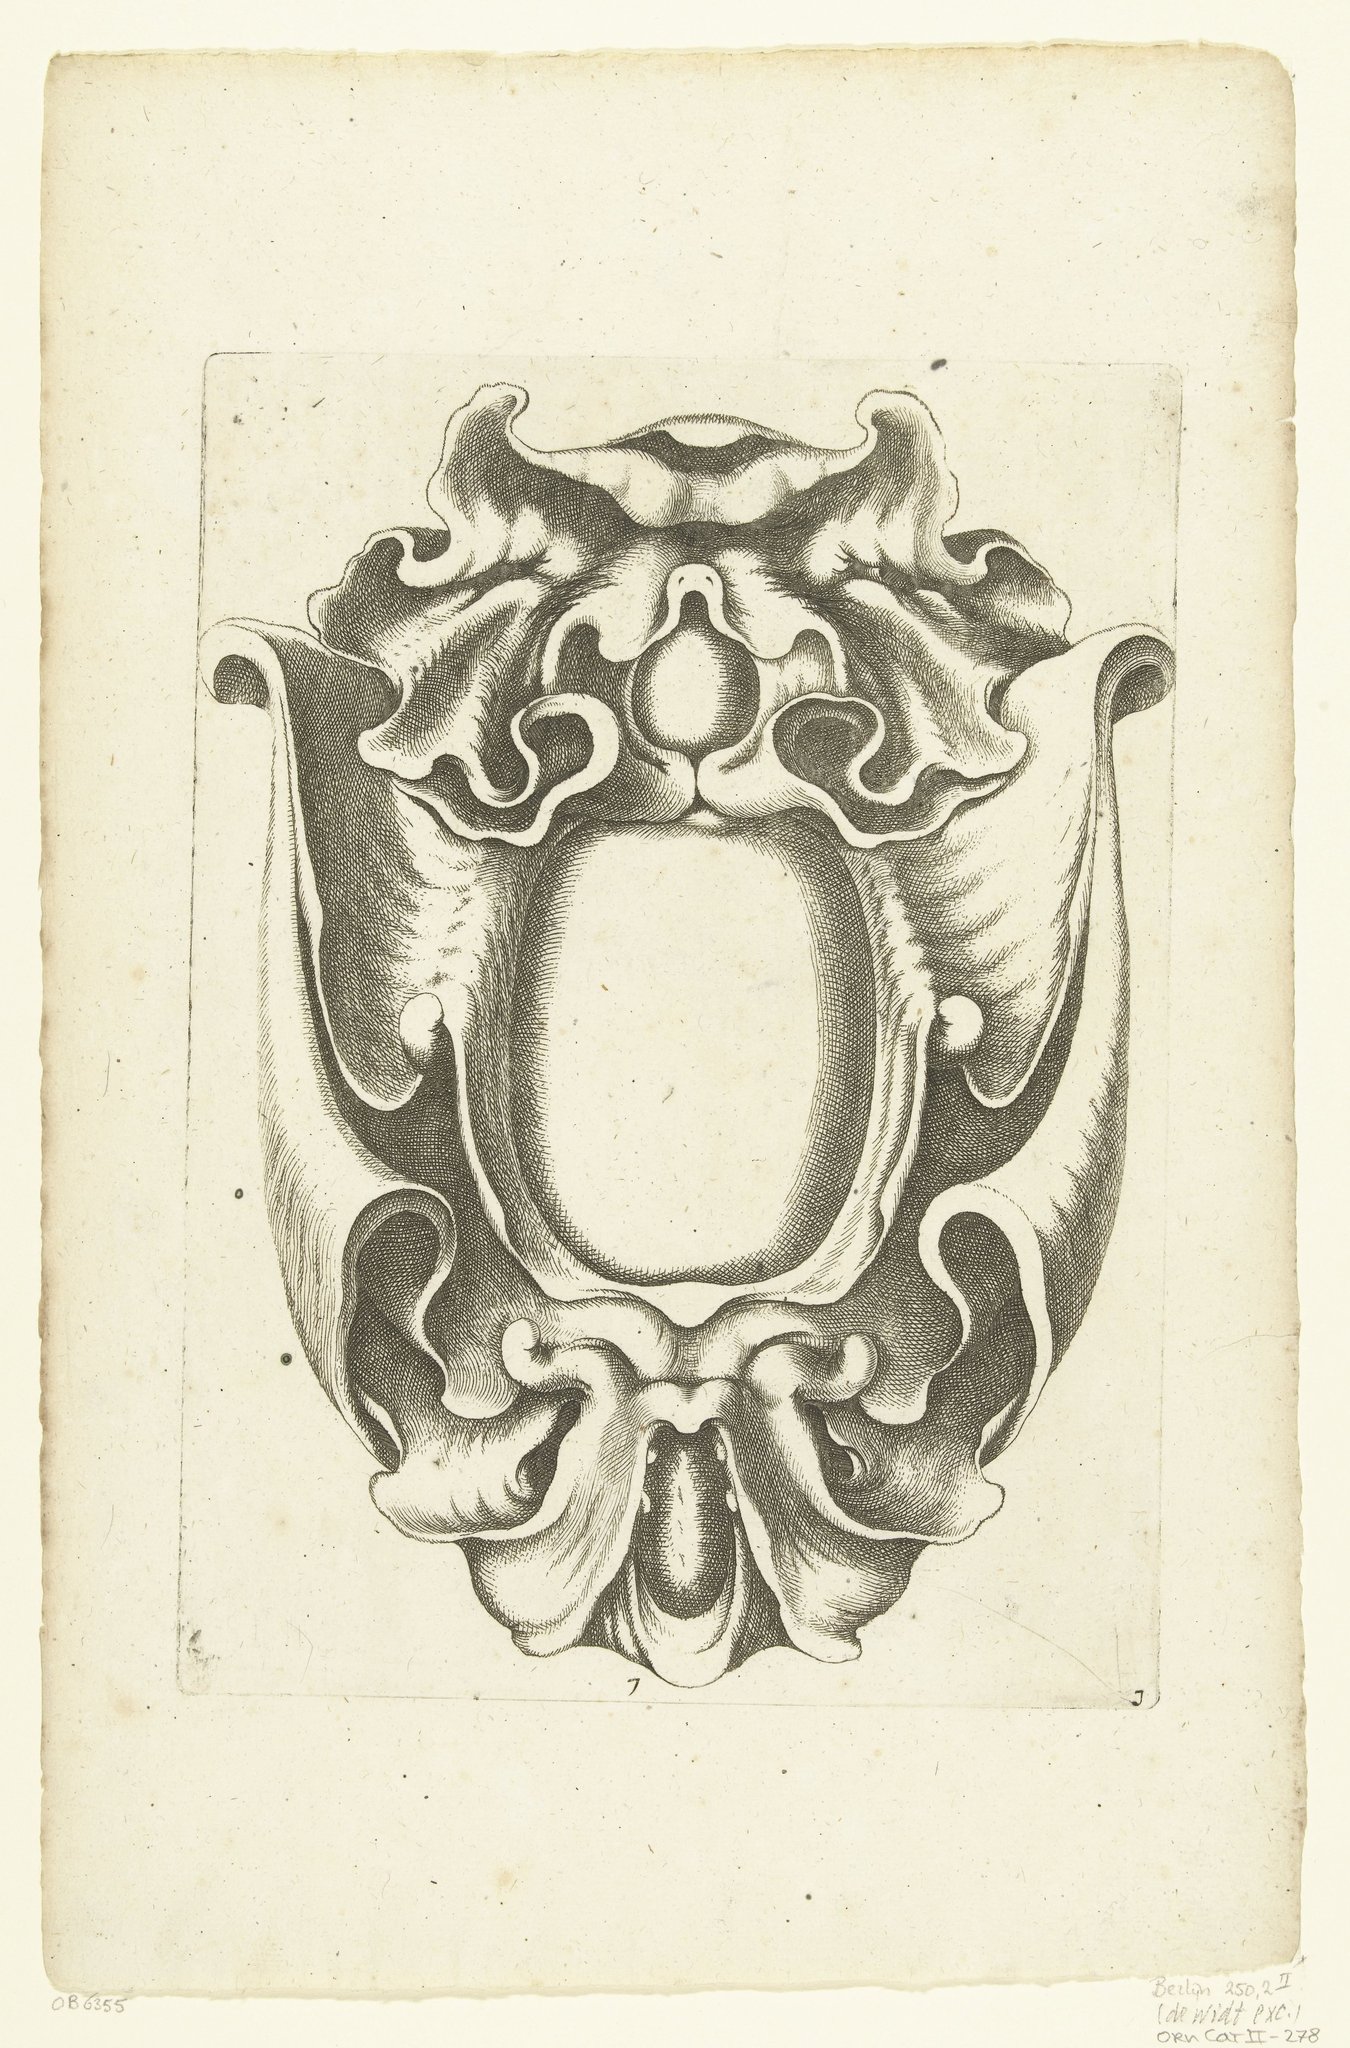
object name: ornament print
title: Cartouche met groot compartiment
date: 1654-1678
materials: paper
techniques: etching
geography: amsterdam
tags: ornament ~ cartouche, mask, mascaron ~ ornament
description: Bovenaan en onderaan een masker met een smal compartiment of gapende mond, aan beide zijkanten vleugelachtige lobben. Prent uit tweede editie van serie.